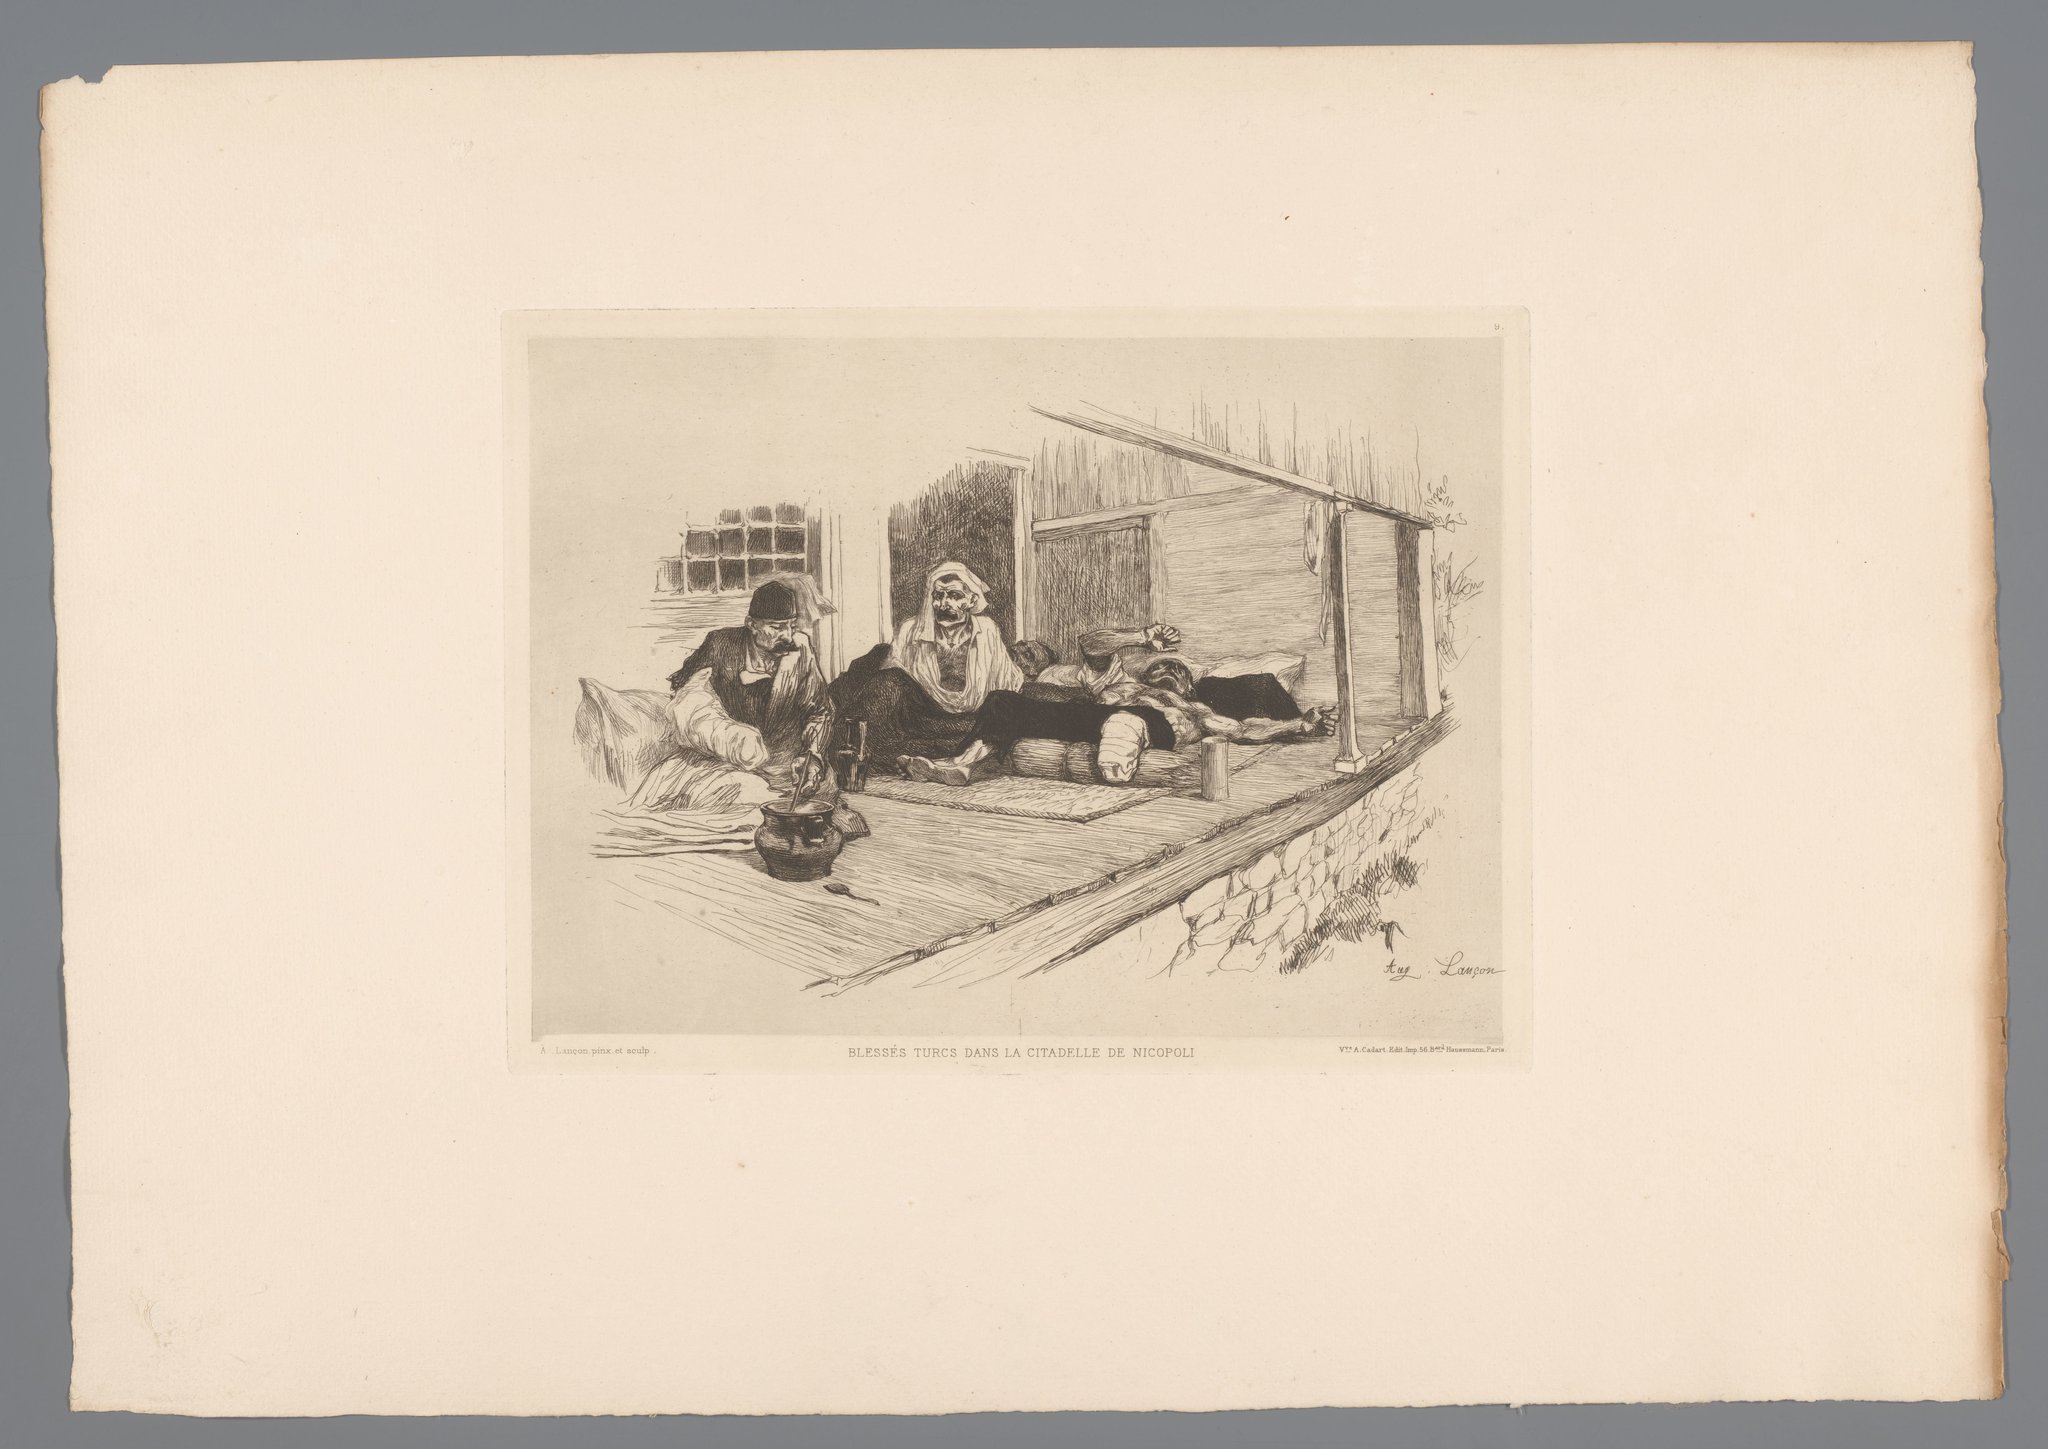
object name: print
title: L'eau-forte en 1880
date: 1880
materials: paper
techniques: drypoint, etching, intaglio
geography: paris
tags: medical aid and nursing of the sick and wounded, patient, sick person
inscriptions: collector's mark: ‘AFE v S’, collector's mark: Lugt 2228, watermark, collector's mark: Lugt 2760